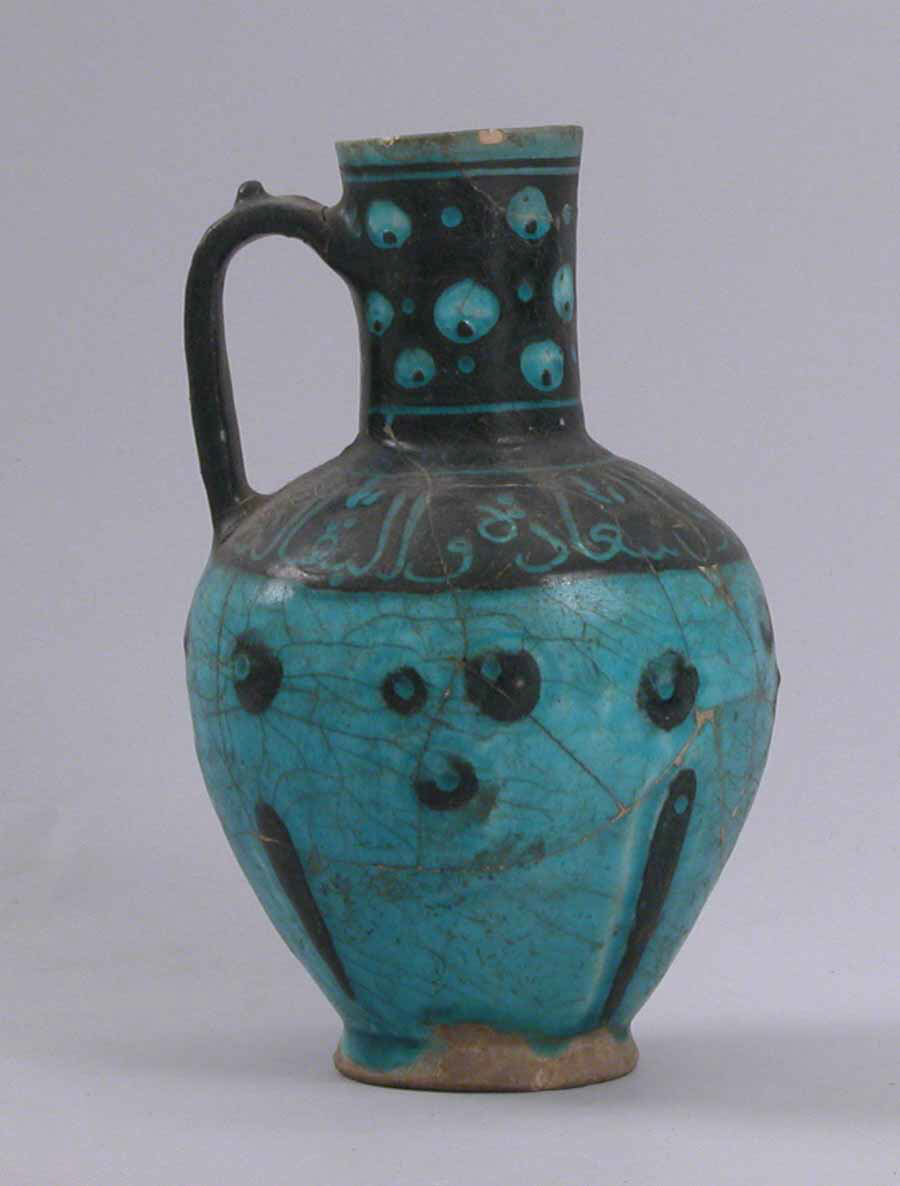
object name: ewer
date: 1201-1300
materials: stonepaste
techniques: glazing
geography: iran